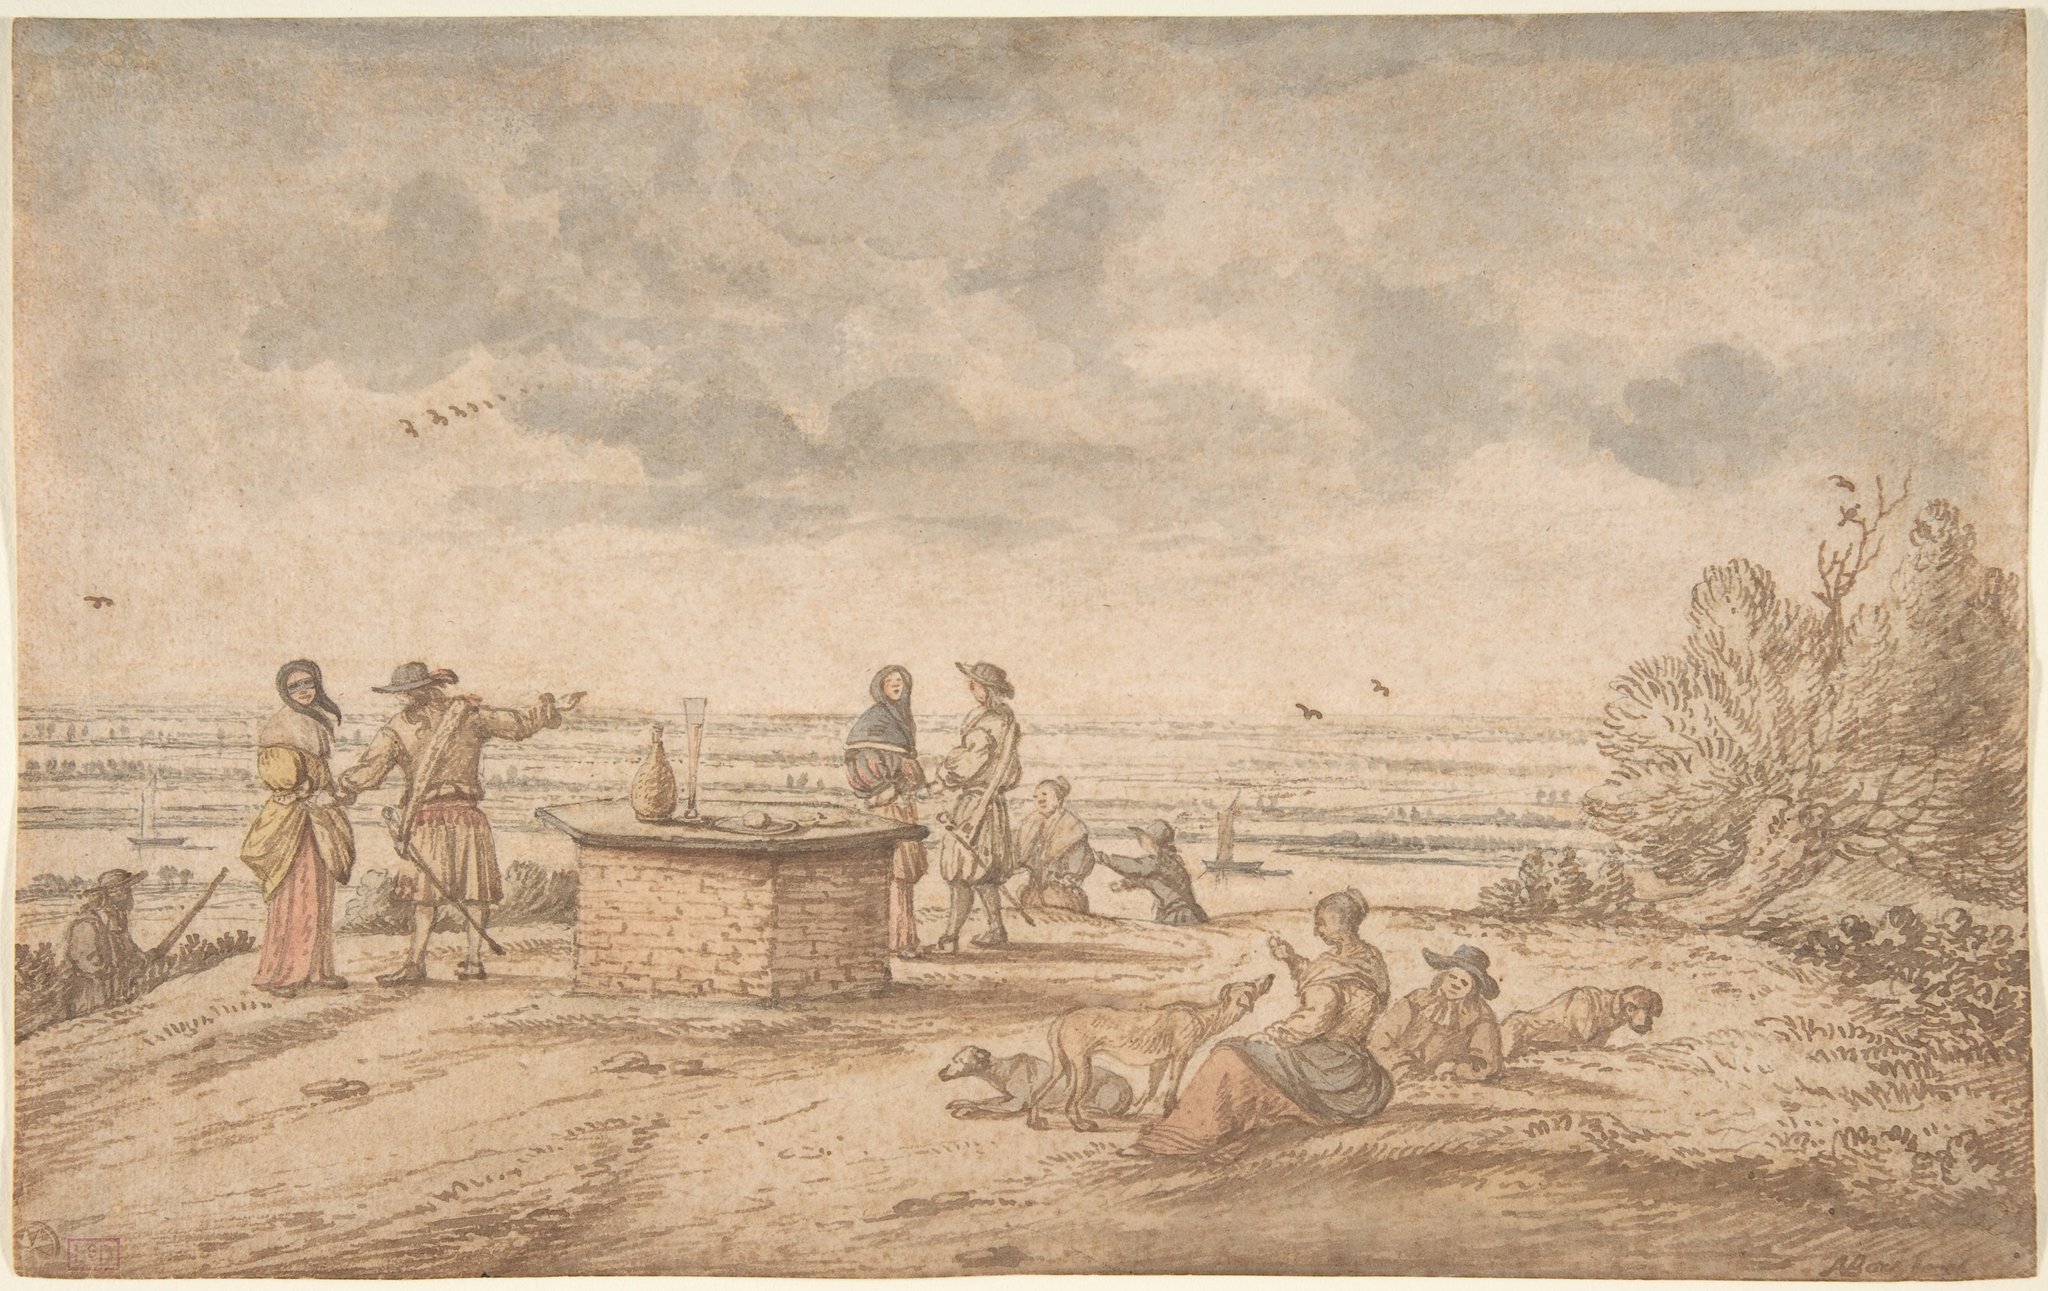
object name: drawing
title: Elegant Party on the Tafelberg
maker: anthonie van borssom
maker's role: artist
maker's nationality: dutch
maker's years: 1631-1677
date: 1601-1700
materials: ink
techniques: brush, pen, wash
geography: rhenen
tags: men,women,party,dogs